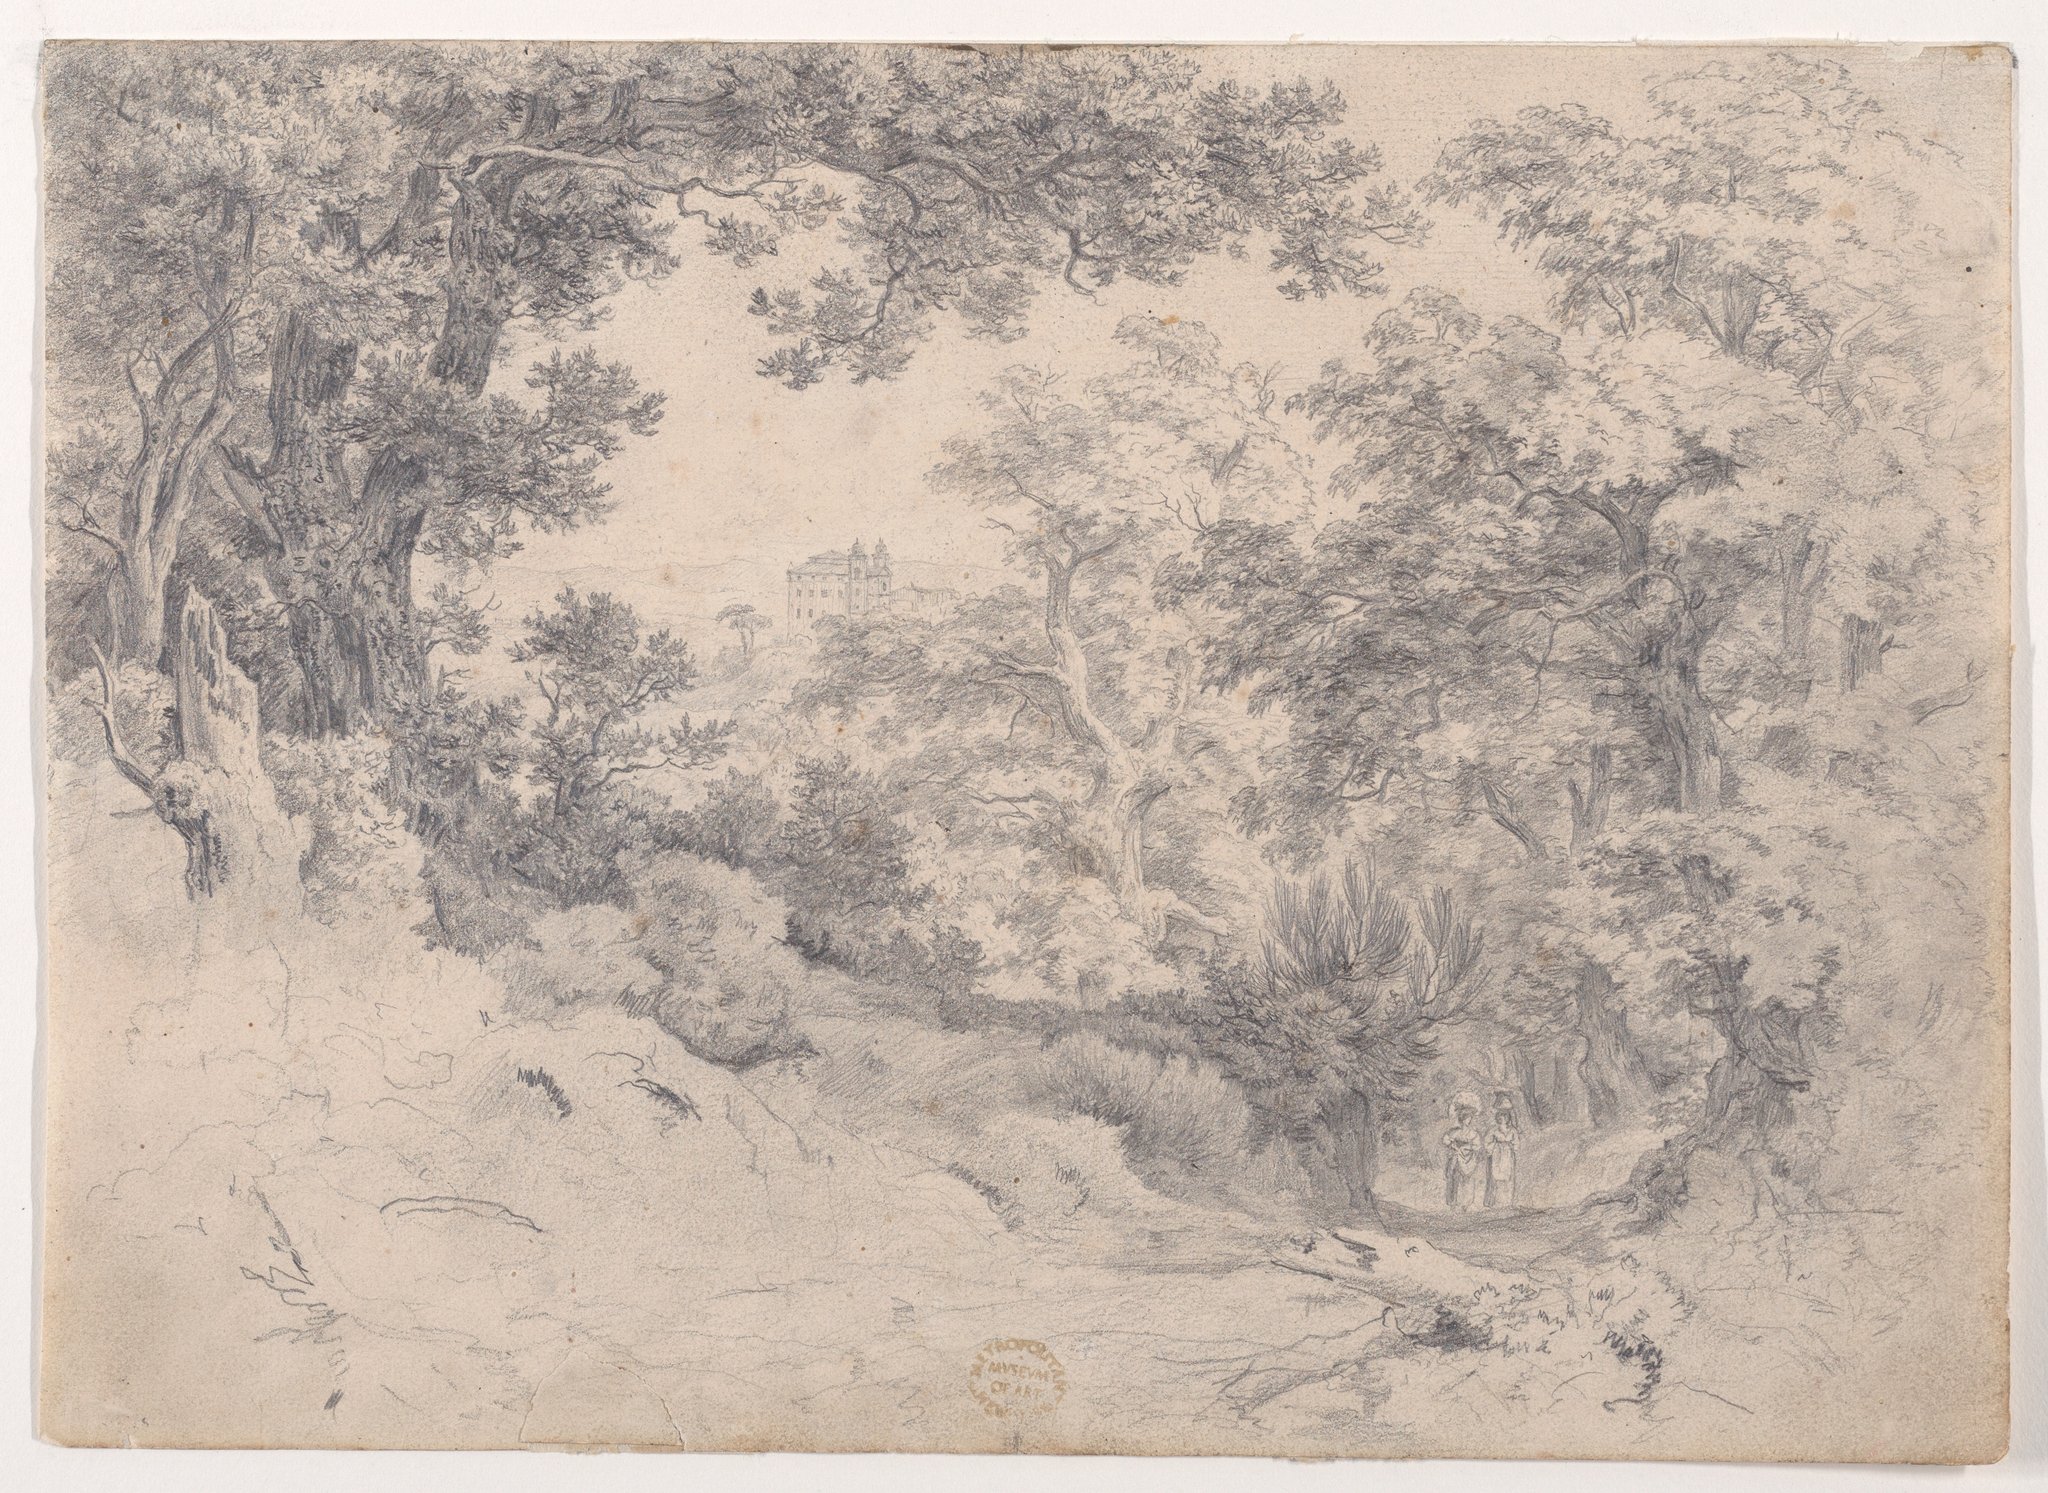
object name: drawing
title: Mediterranean Landscape with a Villa in the Distance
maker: Anonymous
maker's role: artist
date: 1801-1900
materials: graphite